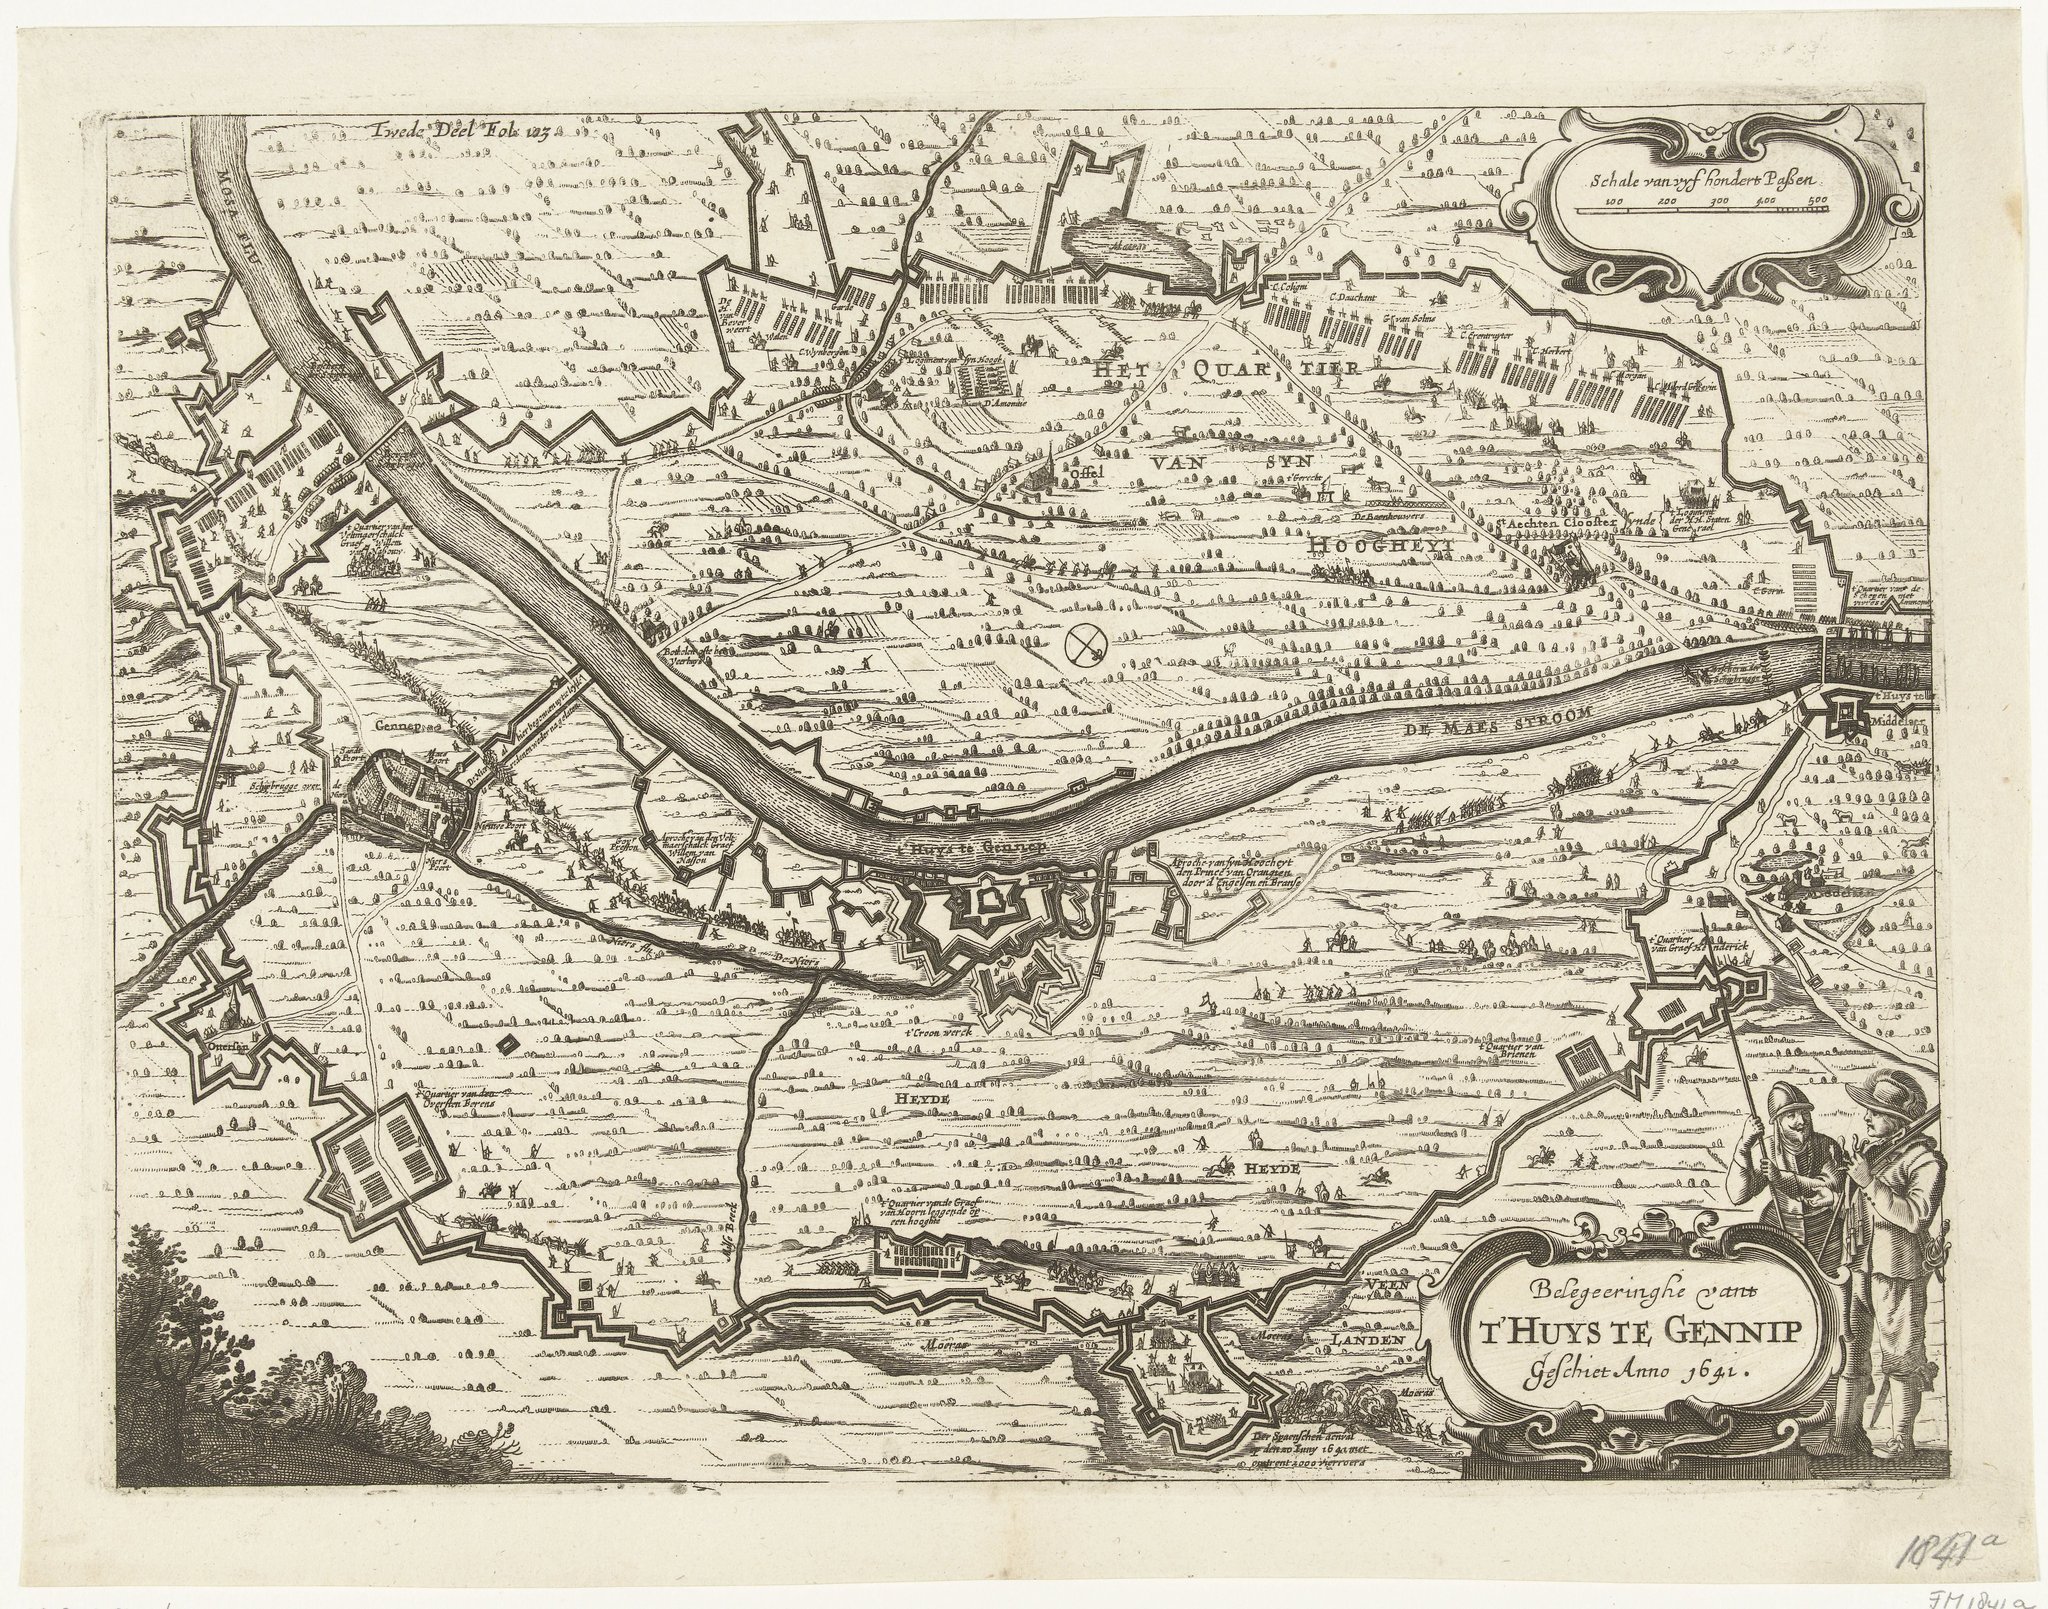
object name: history print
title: Beleegeringhe vant t'Huys te Gennip Geschiet Anno 1641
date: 1649-1651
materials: paper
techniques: etching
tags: delft, the hague, frederick henry (prince of orange), maps of separate countries or regions, siege, position war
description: Kaart van Gennep met het Huis te Gennep en omgeving, belegerd en veroverd door het Staatse leger onder Frederik Hendrik, 6 juni - 27 juli 1641. Met de circumvallatielinie van de belegeraars en de hun legerkampen. Rechtsonderaan twee soldaten bij de cartouche met de titel. Linksboven gemerkt: Twede Deel Fol: 103.